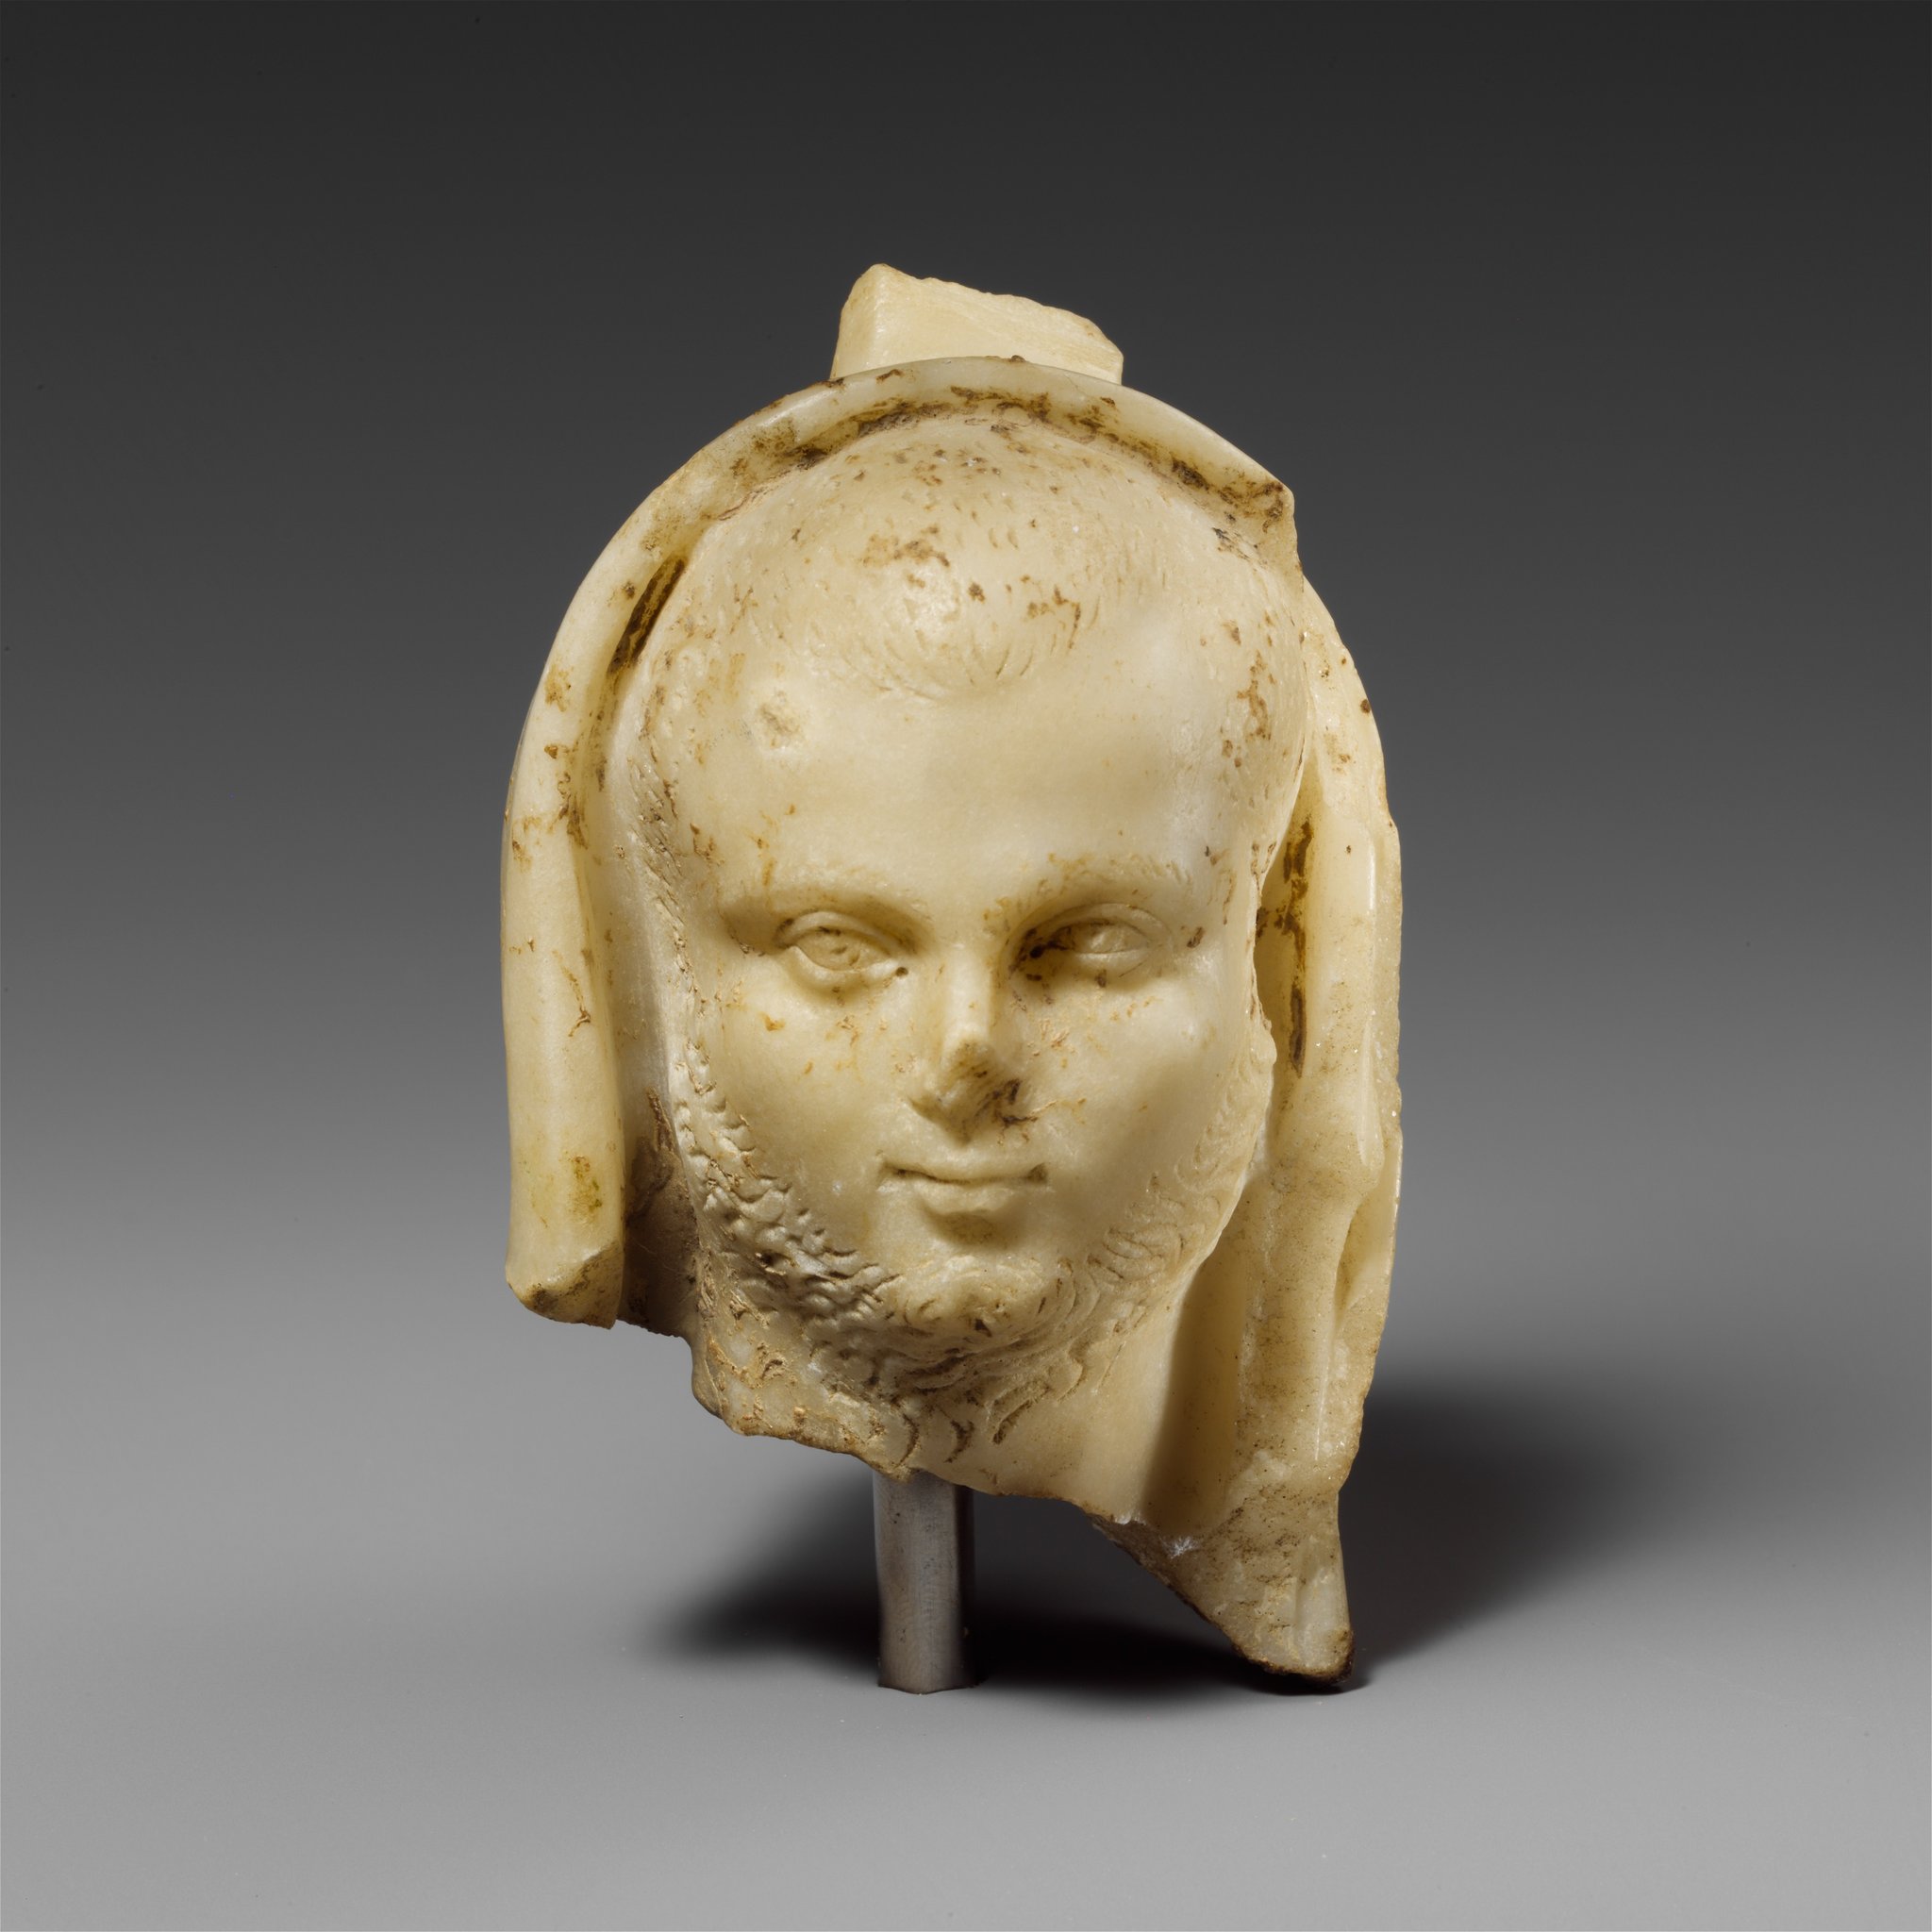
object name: portrait head of a man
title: Marble portrait of a veiled man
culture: roman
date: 234-266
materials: marble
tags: heads,men,portraits